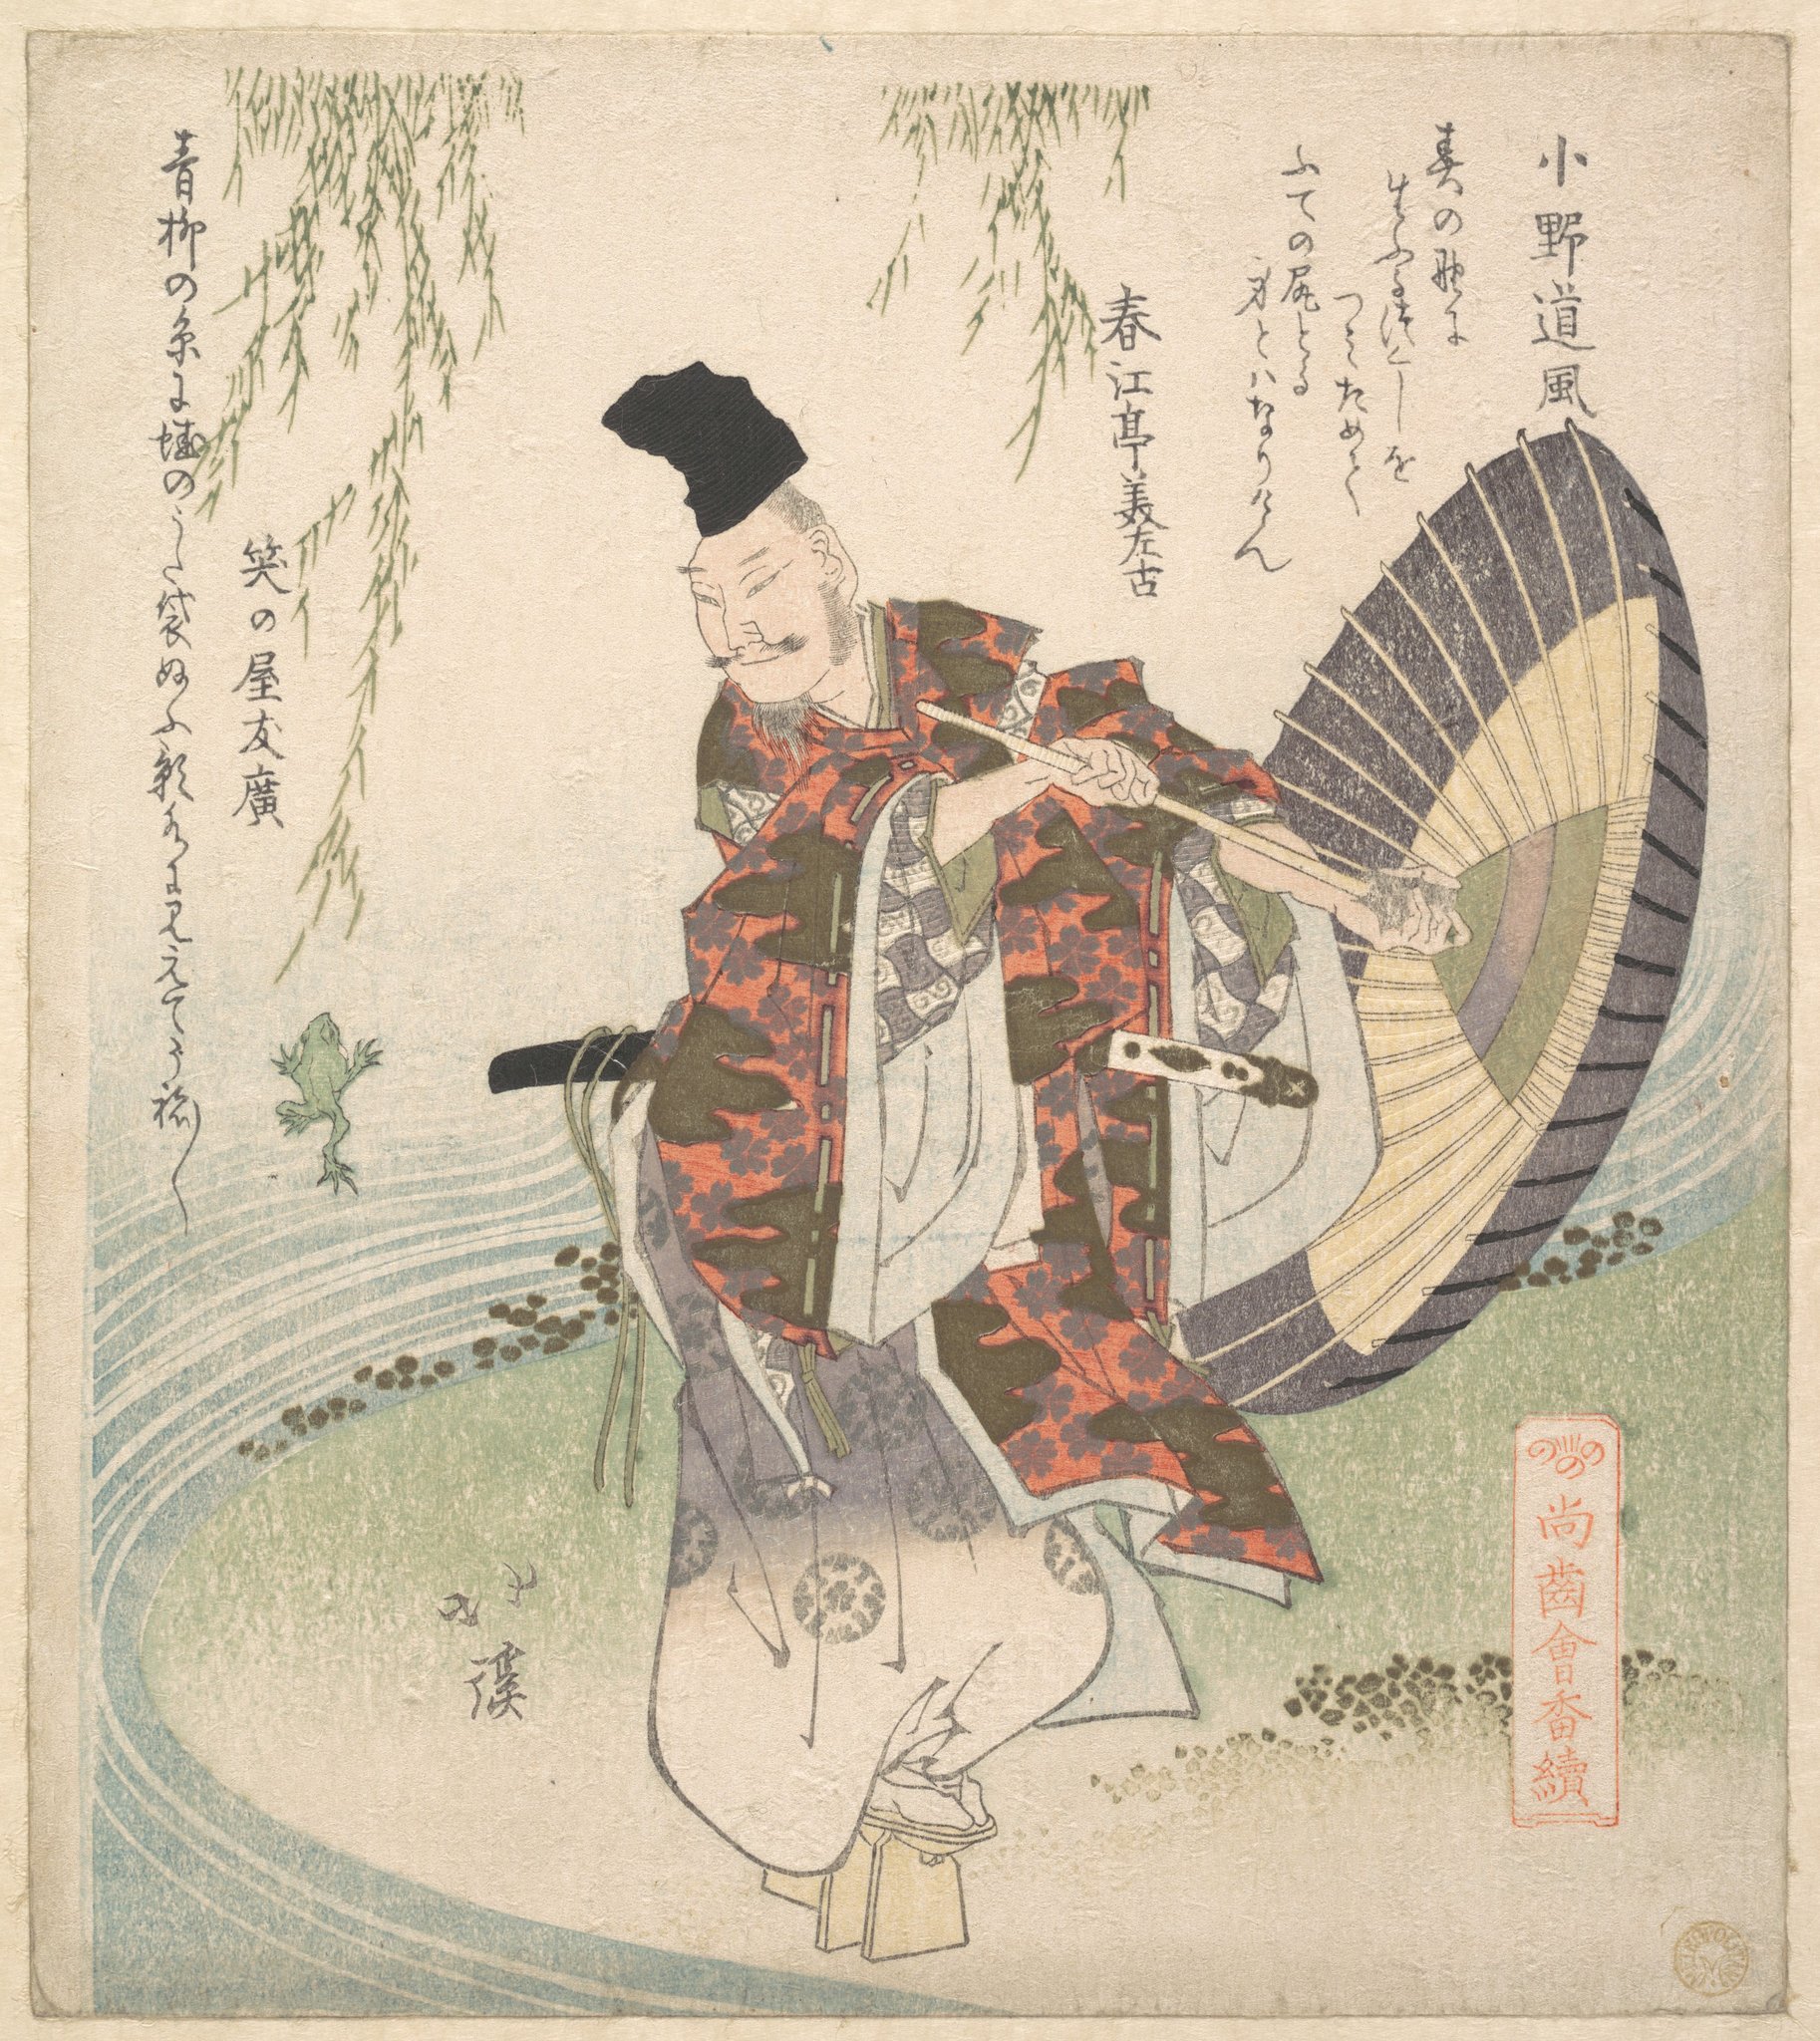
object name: woodblock print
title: Ono no Tofu Standing on the Bank of a Stream and Watching a Frog Leap to Catch a Willow Branch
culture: japanese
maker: totoya hokkei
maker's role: artist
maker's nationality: japanese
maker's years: 1780-1850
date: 1825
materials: ink, paper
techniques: surimono, woodblock print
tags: swords,men,frogs